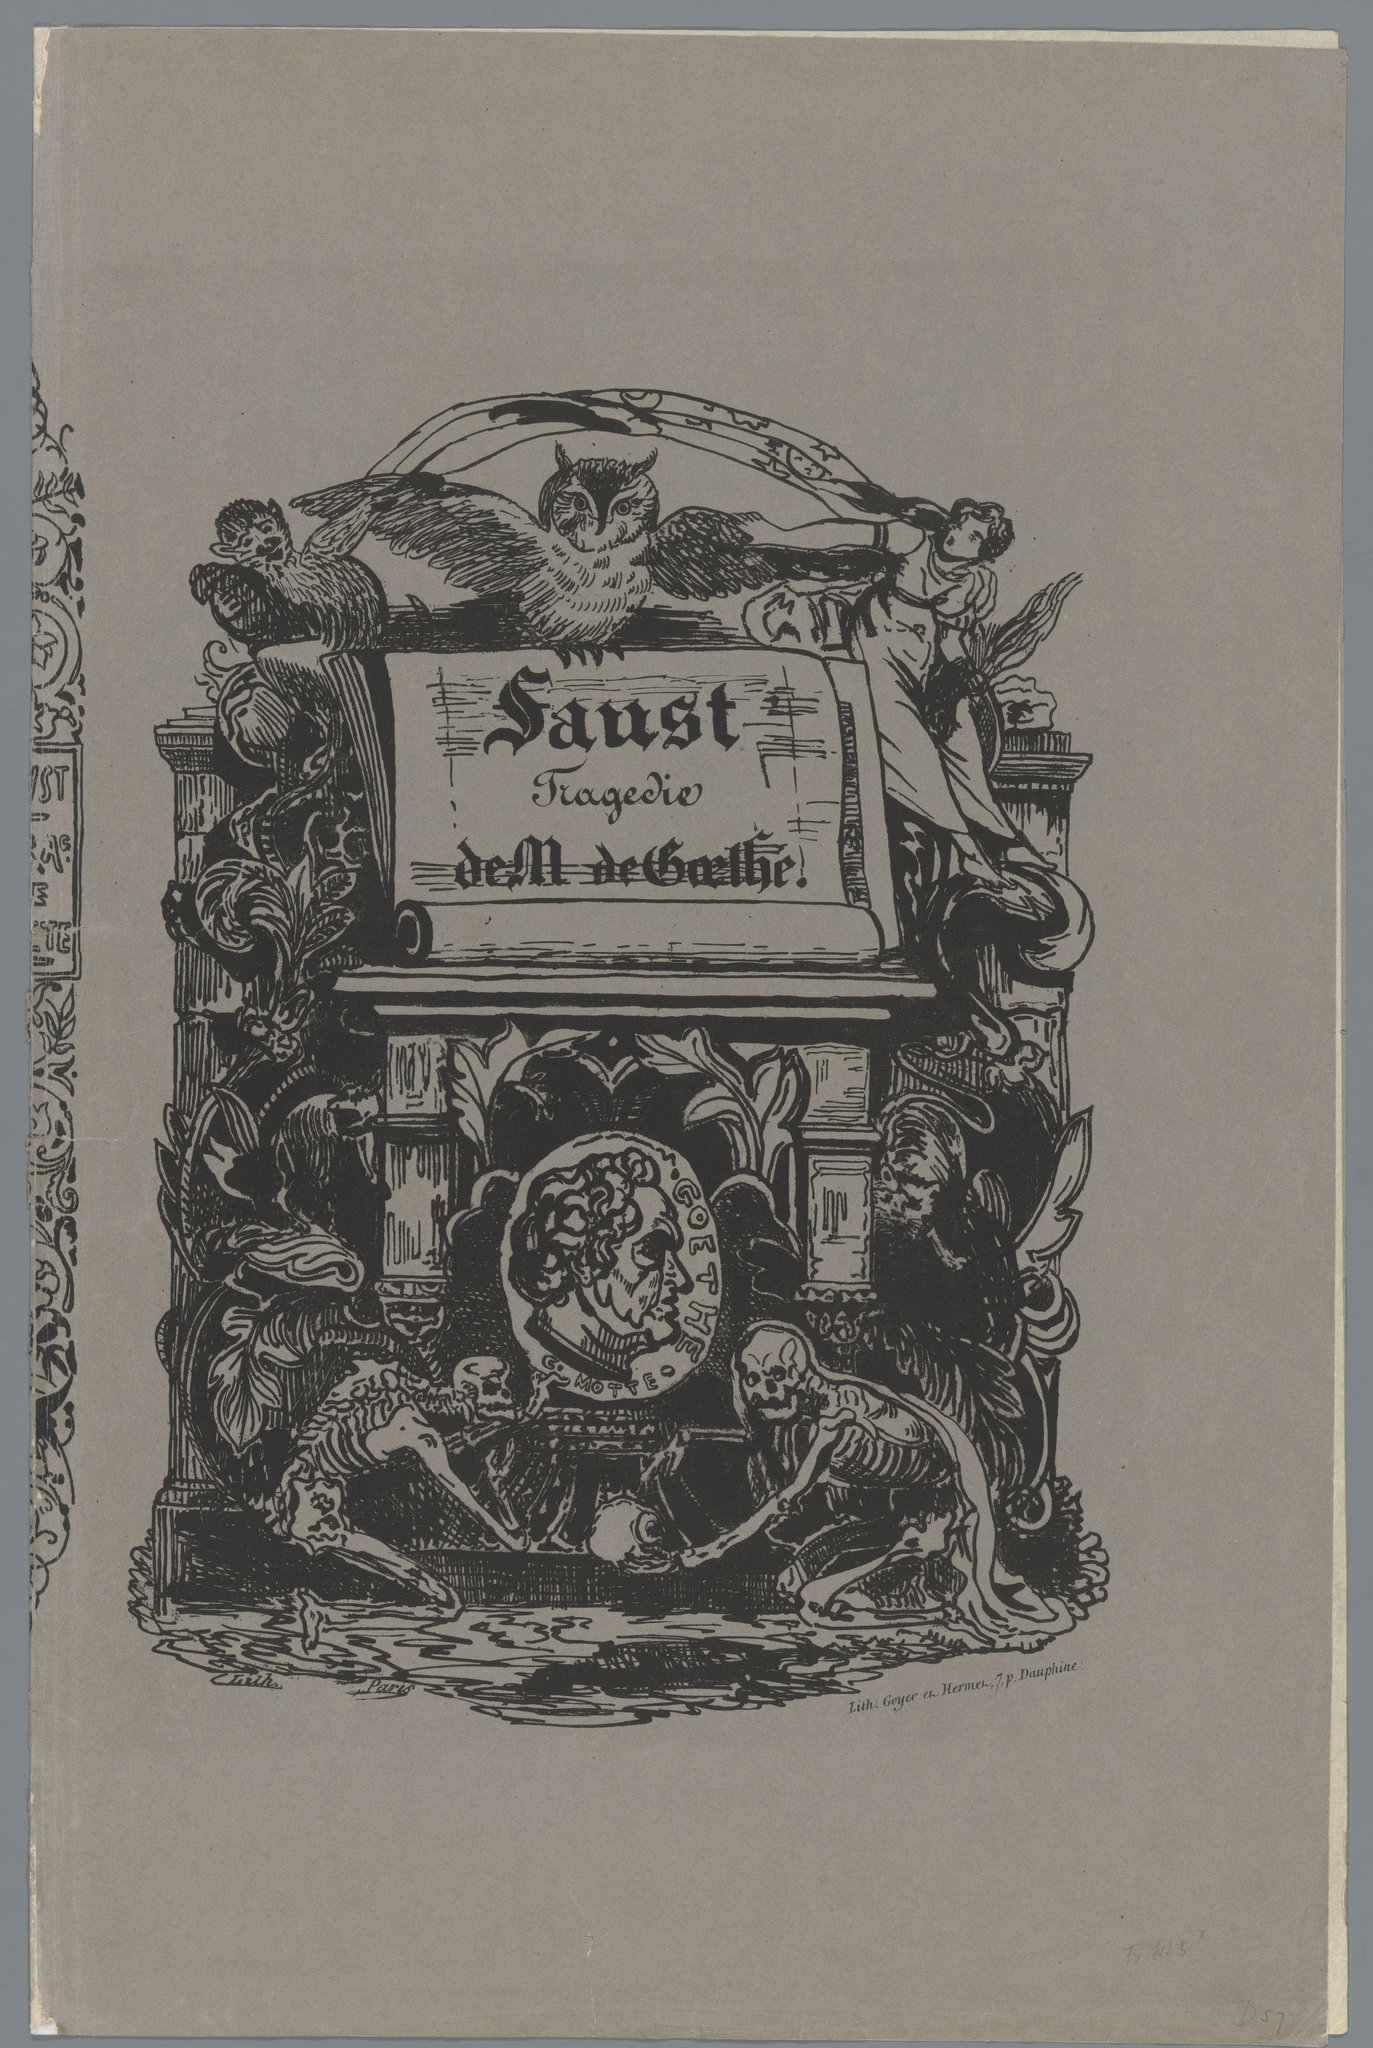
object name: wrapper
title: Faust, tragédie de M. de Goethe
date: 1828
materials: paper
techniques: lithograph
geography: paris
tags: death as skeleton, (scenes from) specific works of literature: goethe, faust